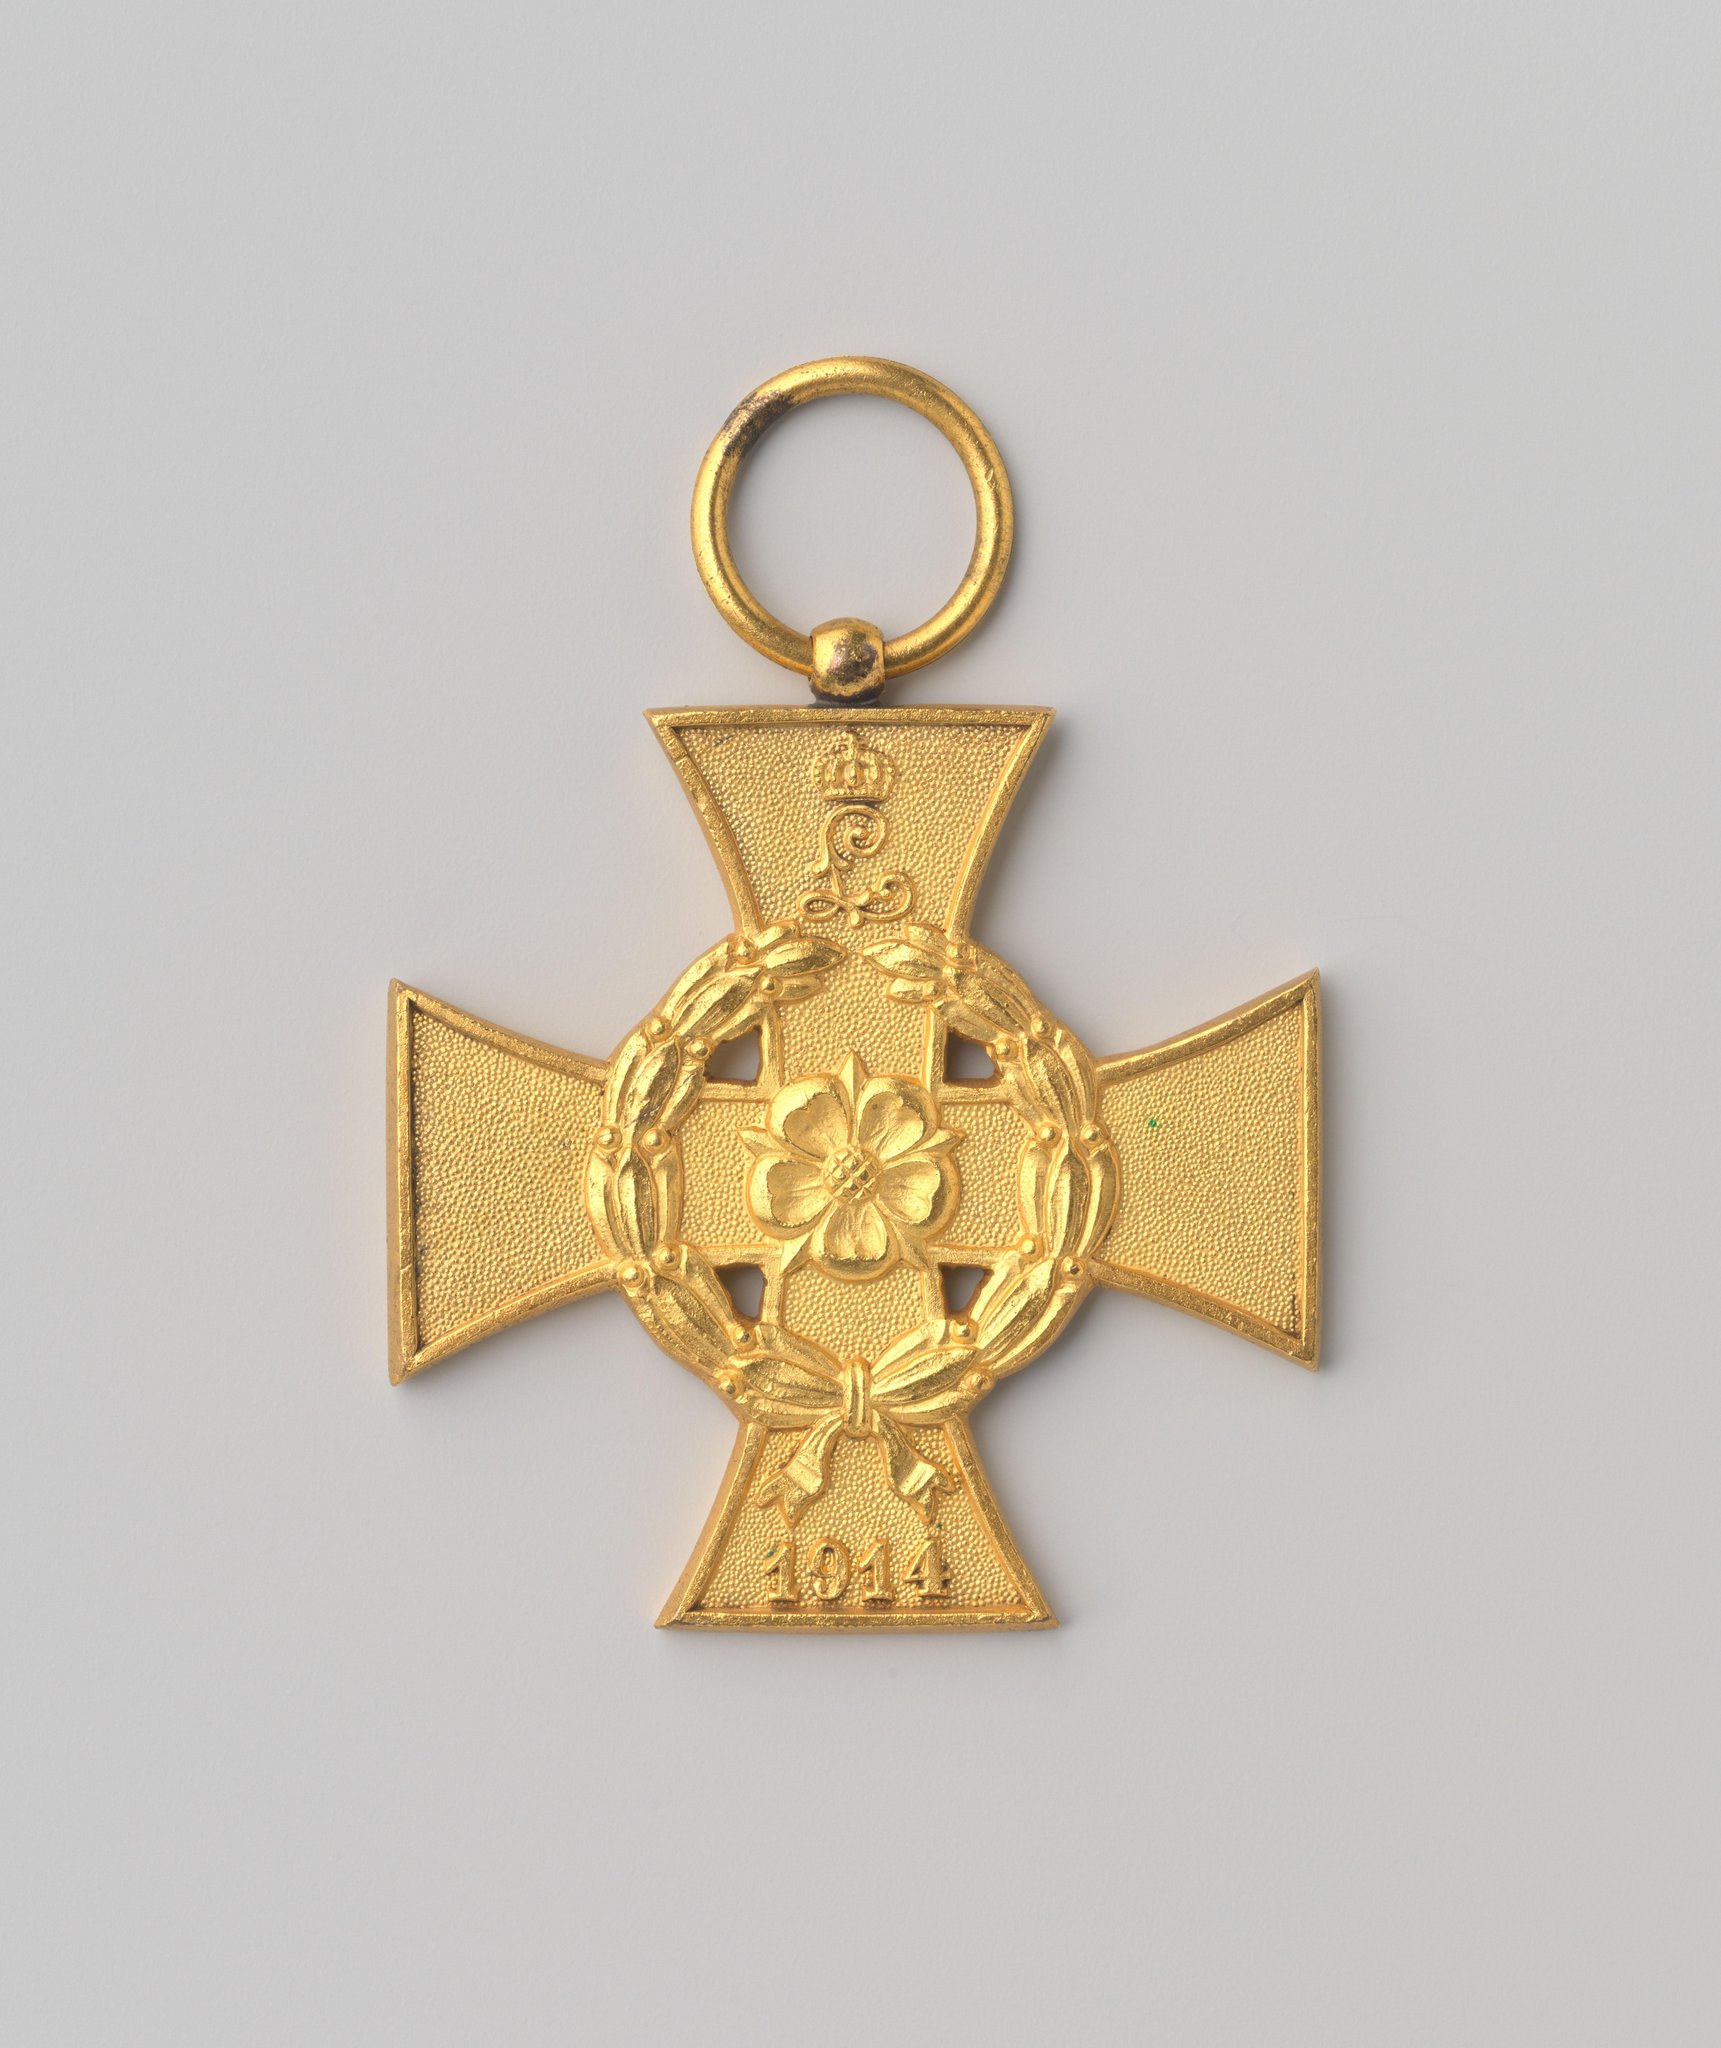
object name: onderscheidingsteken, onderscheiding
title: Kruis voor Oorlogsverdienste 1914 (Lippe-Detmold)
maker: Anonymous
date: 1915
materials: copper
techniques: gilding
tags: eugen wachenheimer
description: Dit object is onderdeel van de nalatenschap van Isabel Elon-Wachenheimer (1928-2010). Tot haar overlijden behoorde het samen met de andere objecten uit de nalatenschap tot haar privédomein van Isabel Wachenheimer. In die particuliere context zijn deze objecten tezamen en individueel aandenkens - aan de jeugd, ouders en familie van Isabel Wachenheimer vóór en tijdens de Shoah en aan haar leven na de Tweede Wereldoorlog. Isabel Wachenheimer, die van juni 1943 tot mei 1945 gevangen zat in Kamp Westerbork, Theresienstadt, Auschwitz, Lenzing a/d Oberdonau (een buitenkamp van Mauthausen), overleefde de Shoah. Haar ouders – Eugène Wachenheimer en Else Wachenheimer-Moos - werden op 14 oktober 1944 in Auschwitz-Birkenau vermoord.